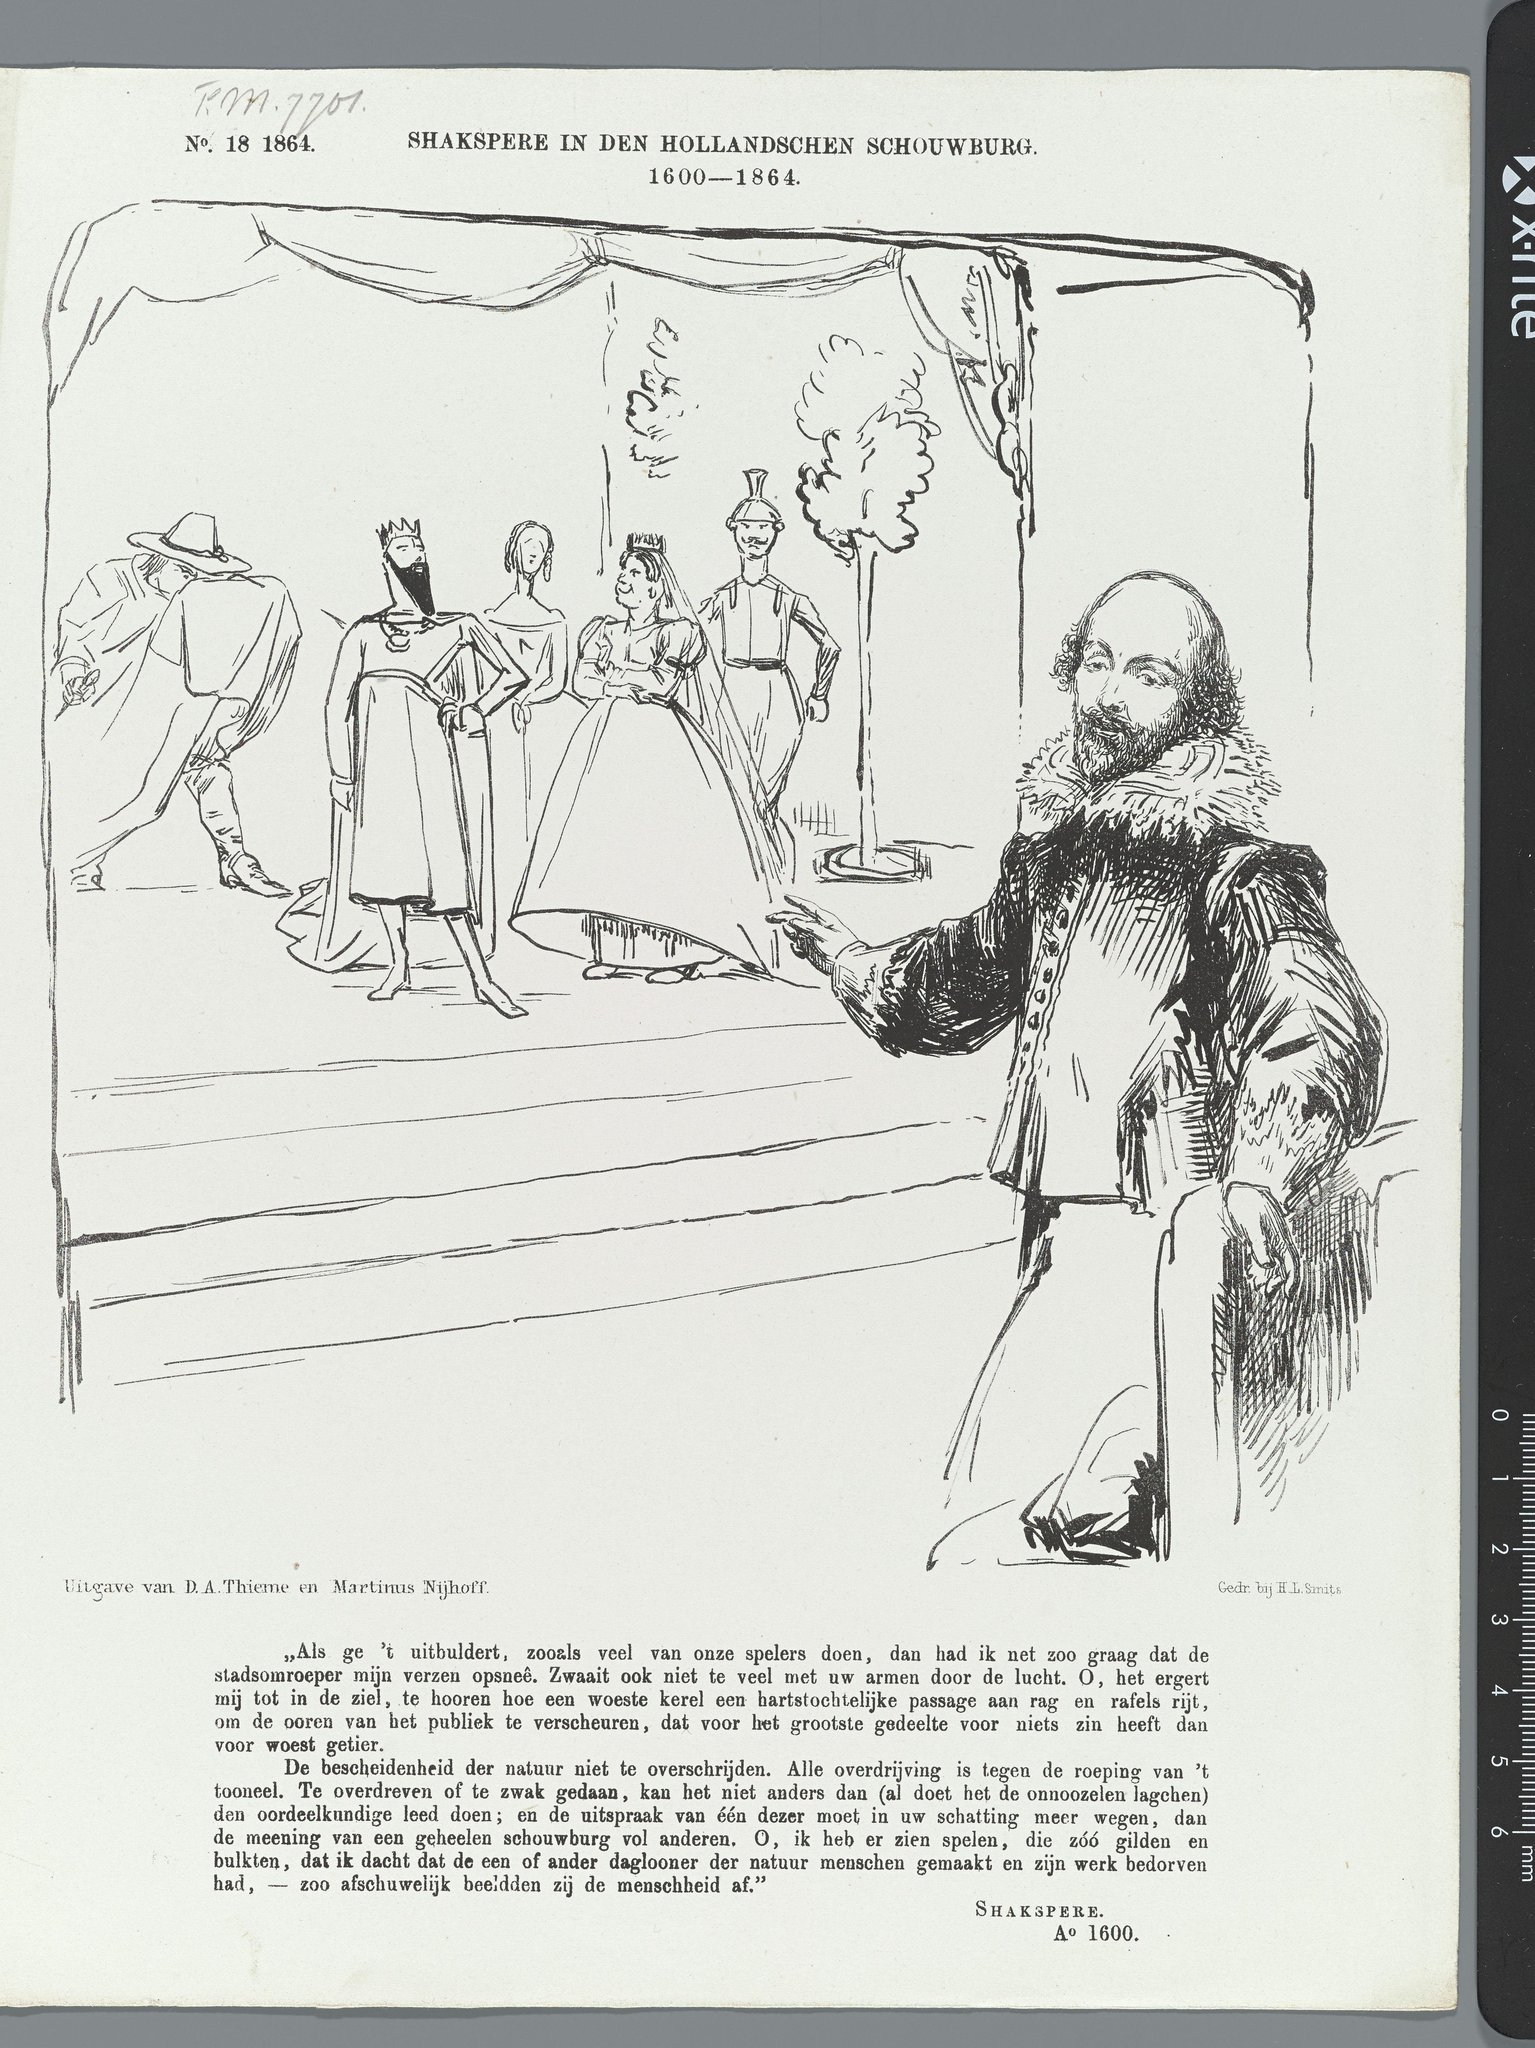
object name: print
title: Shakspere in den Hollandschen Schouwburg. 1600-1864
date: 1864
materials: paper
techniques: lithograph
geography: netherlands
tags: william shakespeare, group of actors, troupe; actors on the stage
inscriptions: collector's mark: Lugt 2228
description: Spotprent op het overdreven spel van sommige toneelspelers. William Shakespeare staande voor een toneel. Plaat verschenen bij het weekblad De Nederlandsche Spectator, nr. 18, 30 april 1864.